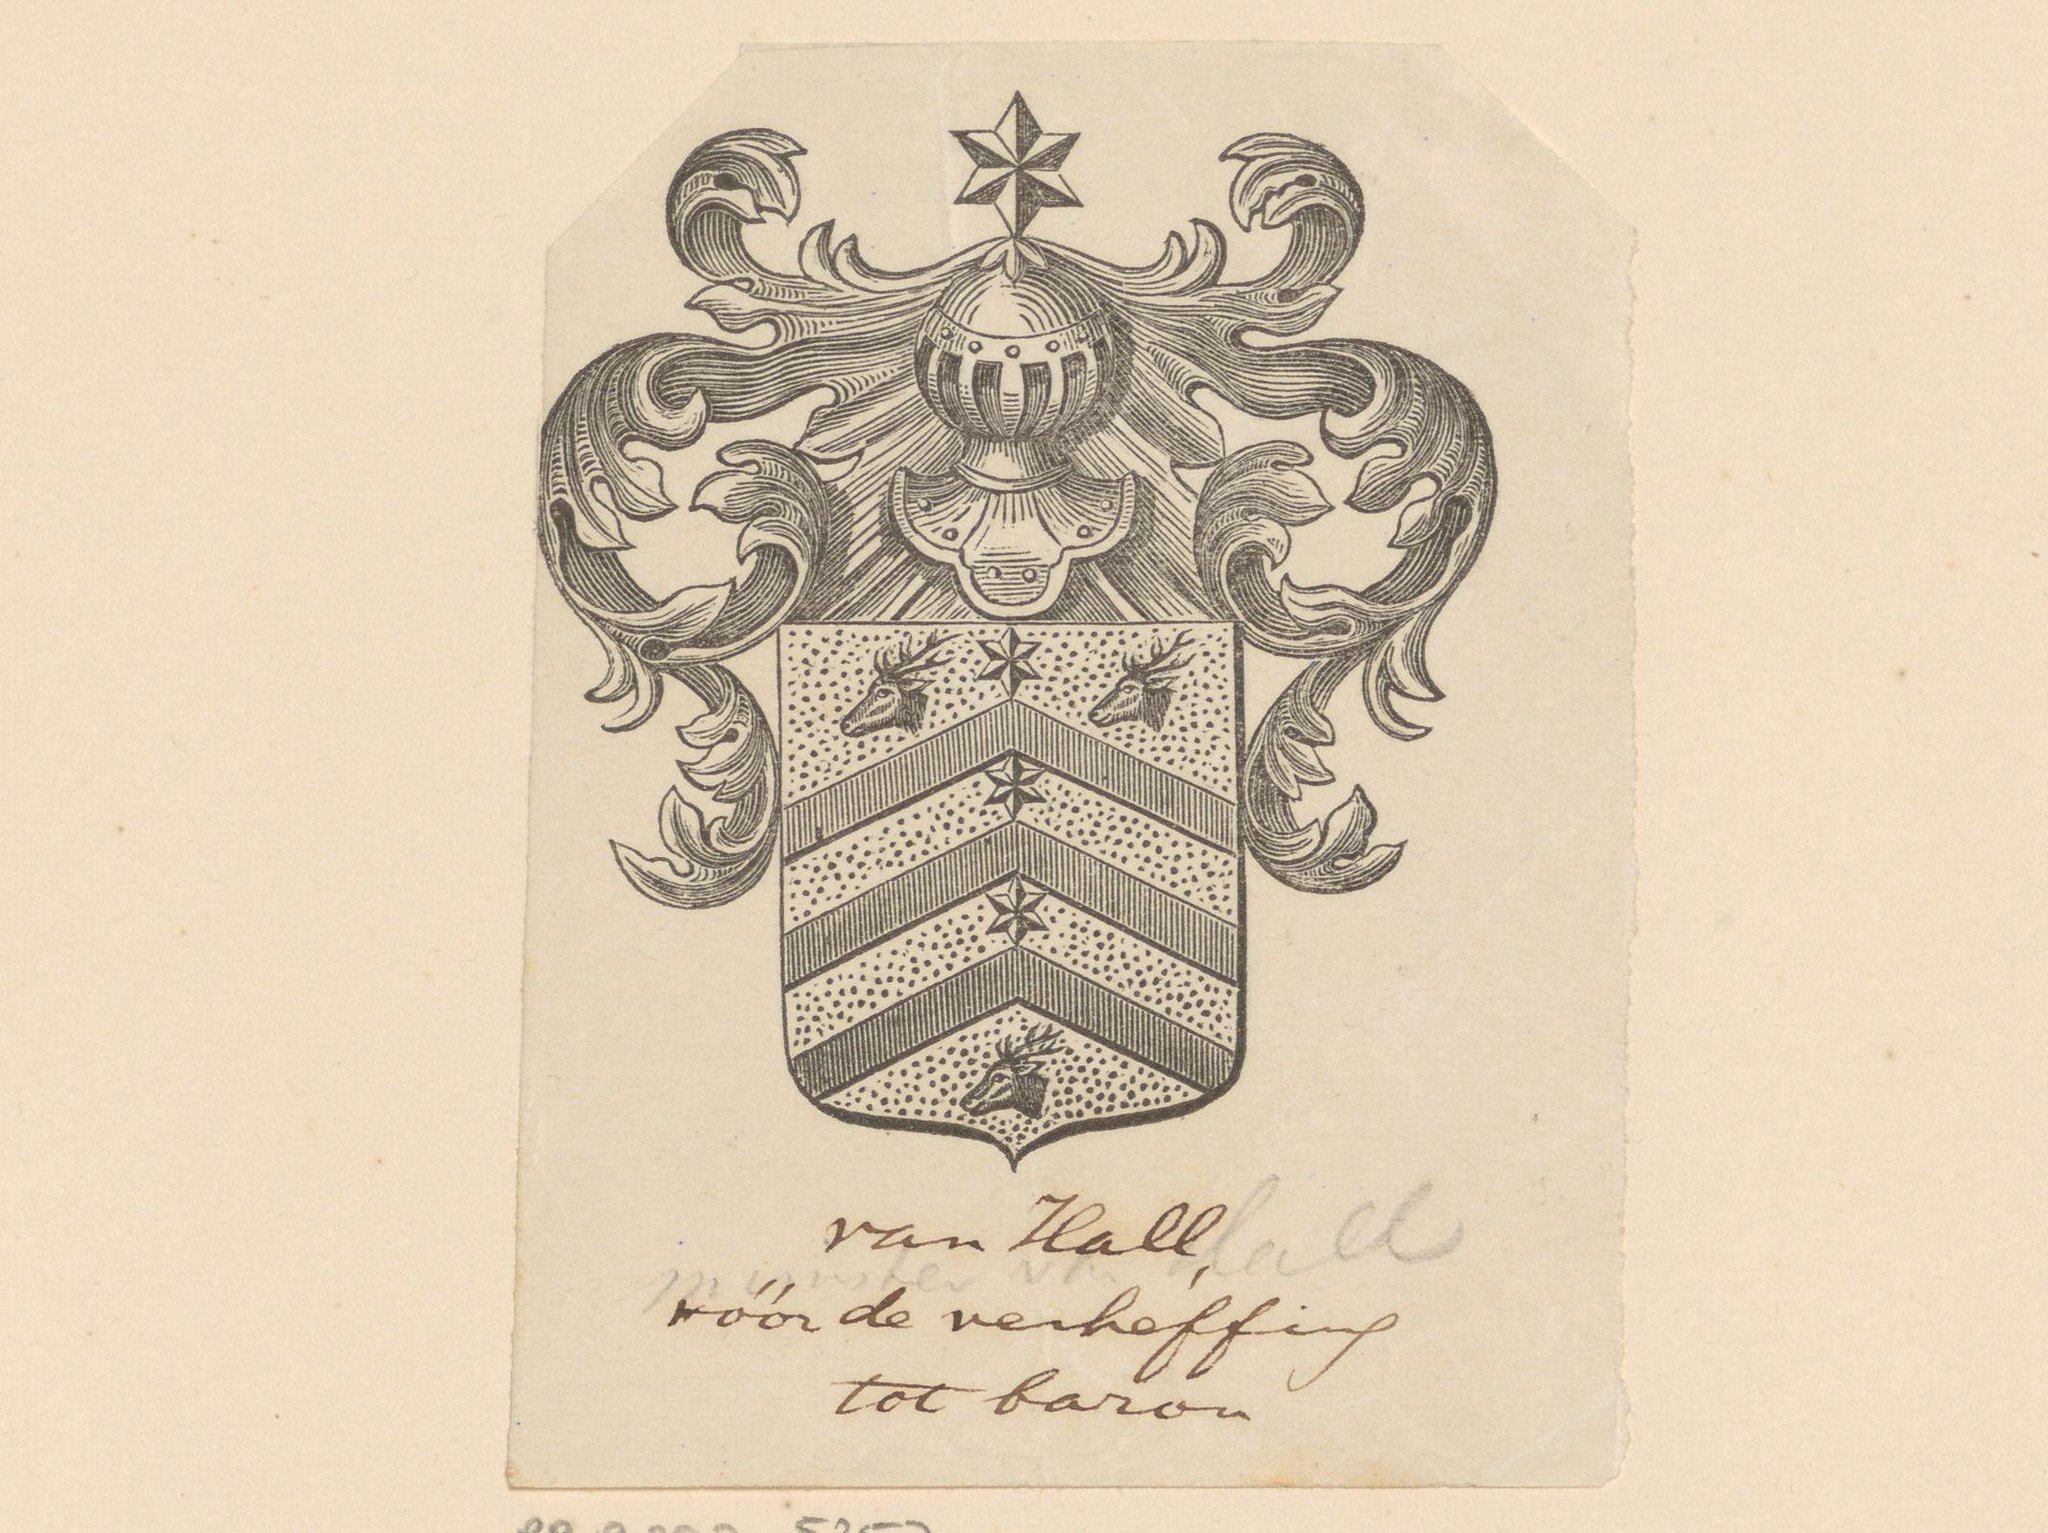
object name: bookplate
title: Ex libris van Floris Adriaan van Hall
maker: Anonymous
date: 1801-1866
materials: paper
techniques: printing block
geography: netherlands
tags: floris adriaan van hall, hoofed animals: deer, armorial bearing, heraldry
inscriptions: inscription: ‘van Hall / vóór de verheffing / tot baron’, inscription: ‘minister van Hall’